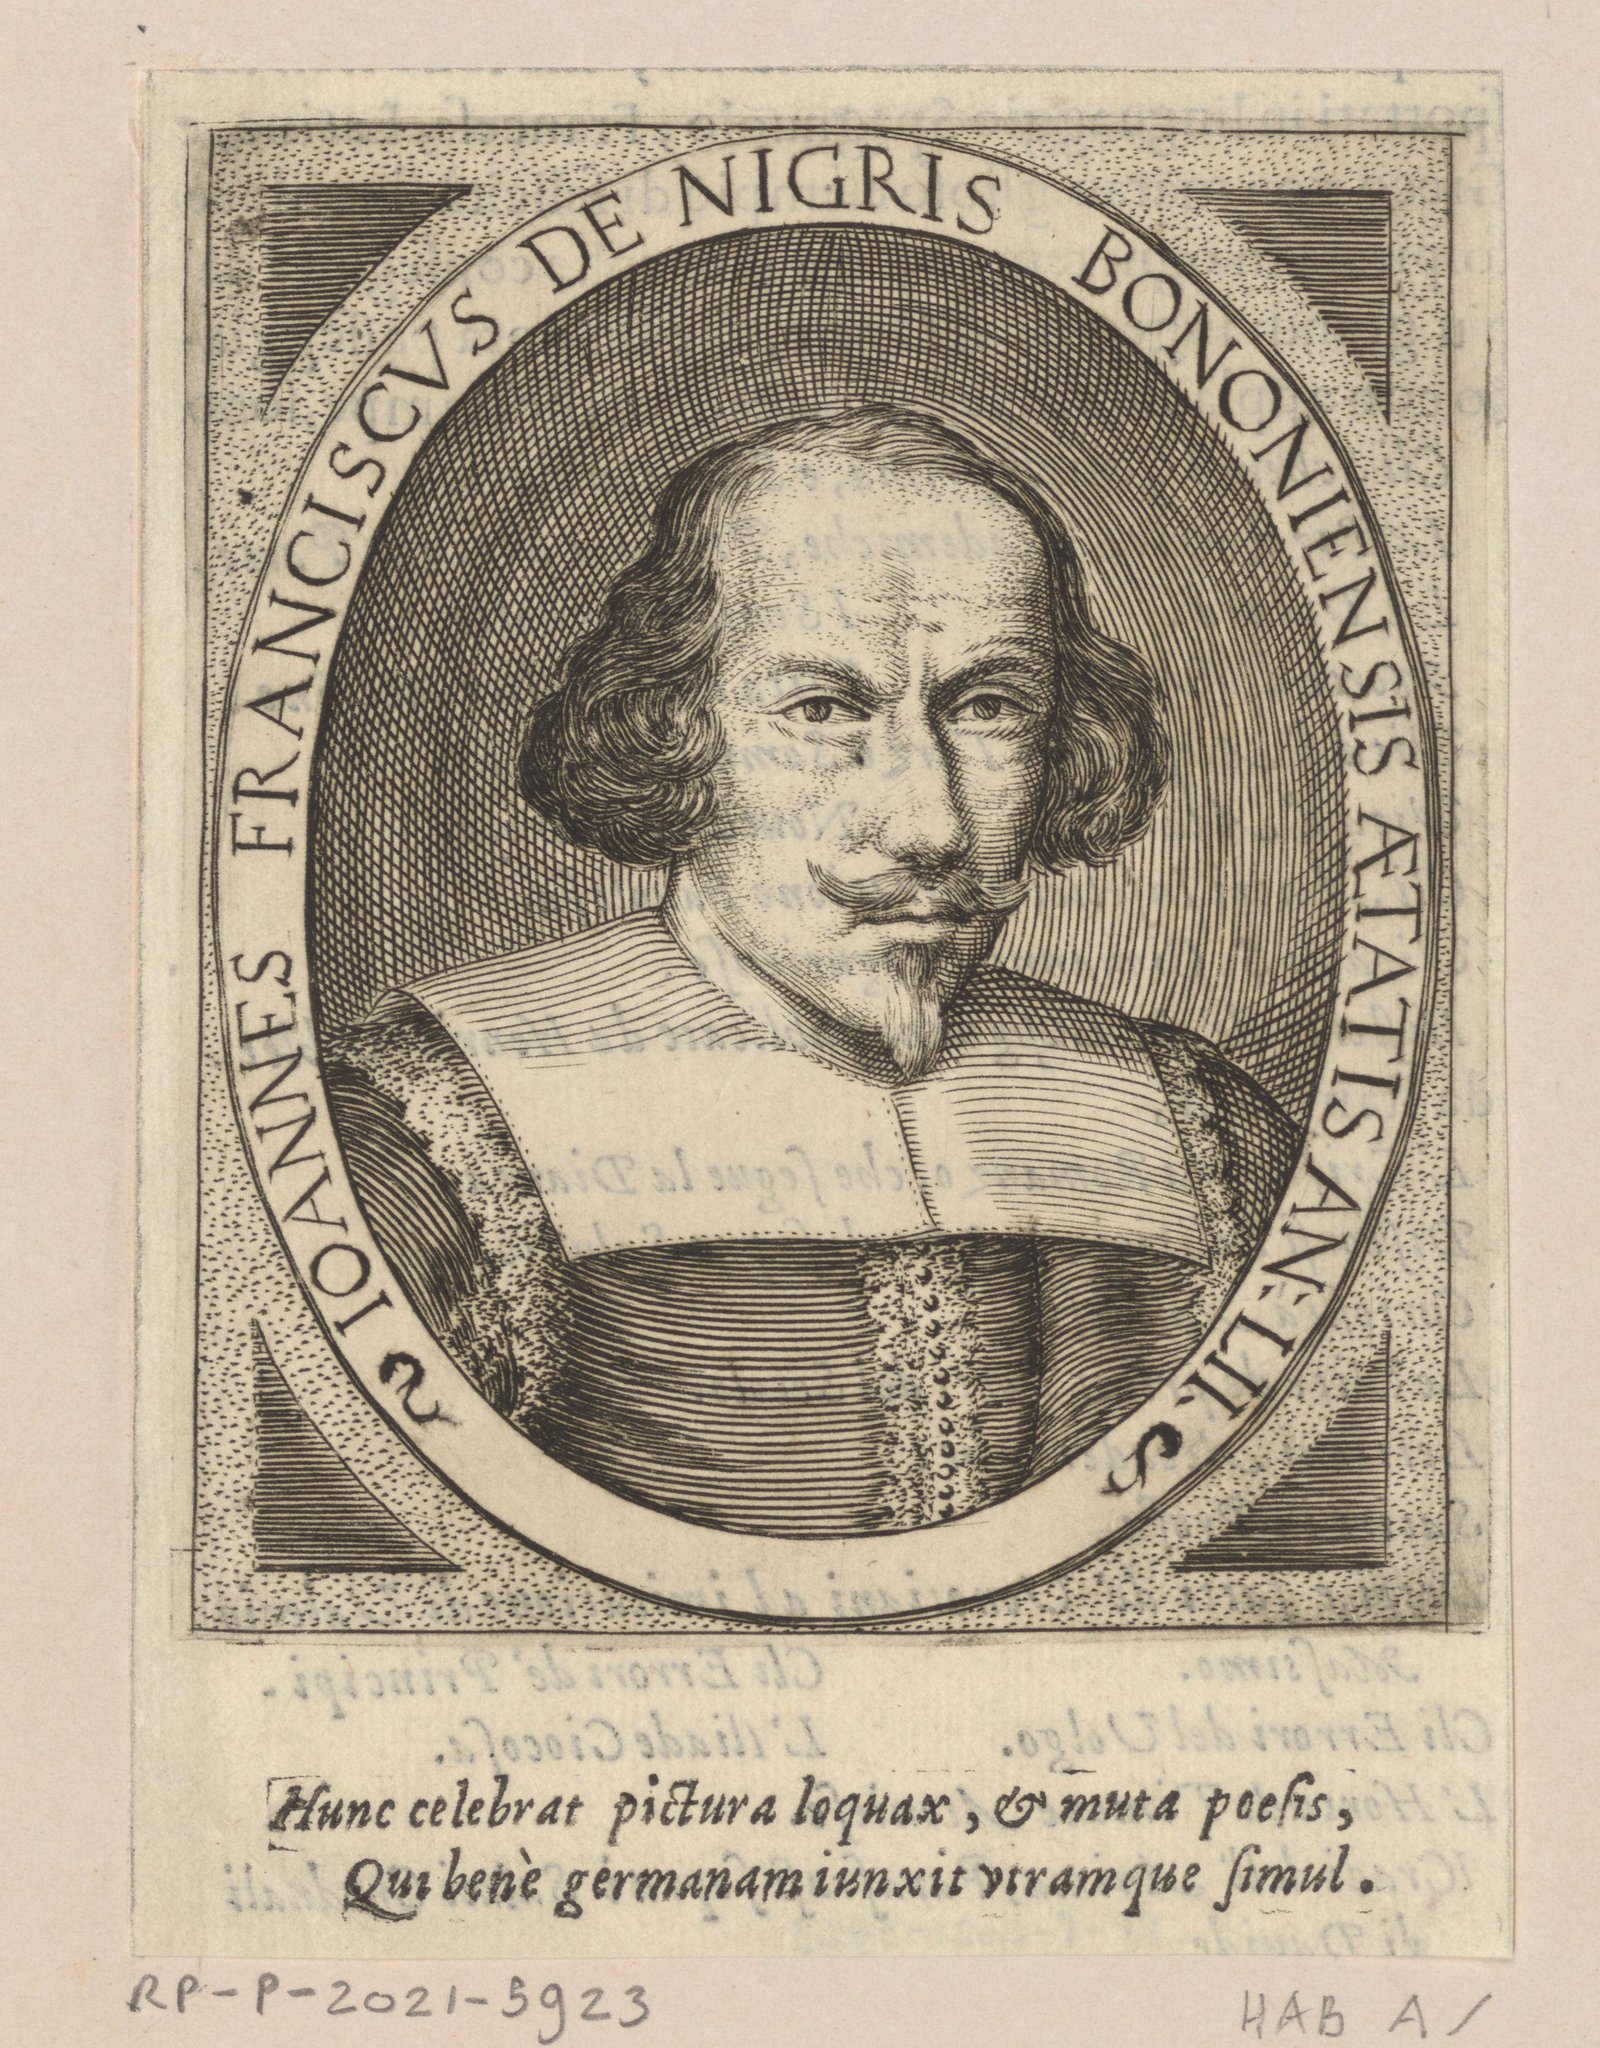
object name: print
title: Portret van Giovanni Francesco Negri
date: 1647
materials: paper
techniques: engraving, letterpress printing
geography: venice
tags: historical persons, portrait, self-portrait of painter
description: Prent uit: Brusoni, Girolam en Giovanni Francesco Loredano. Le glorie de gli Incogniti o vero gli huomini illustri dell'Accademia de' signori Incogniti di Venetia. Venetië: Francesco Valvasense, 1647.